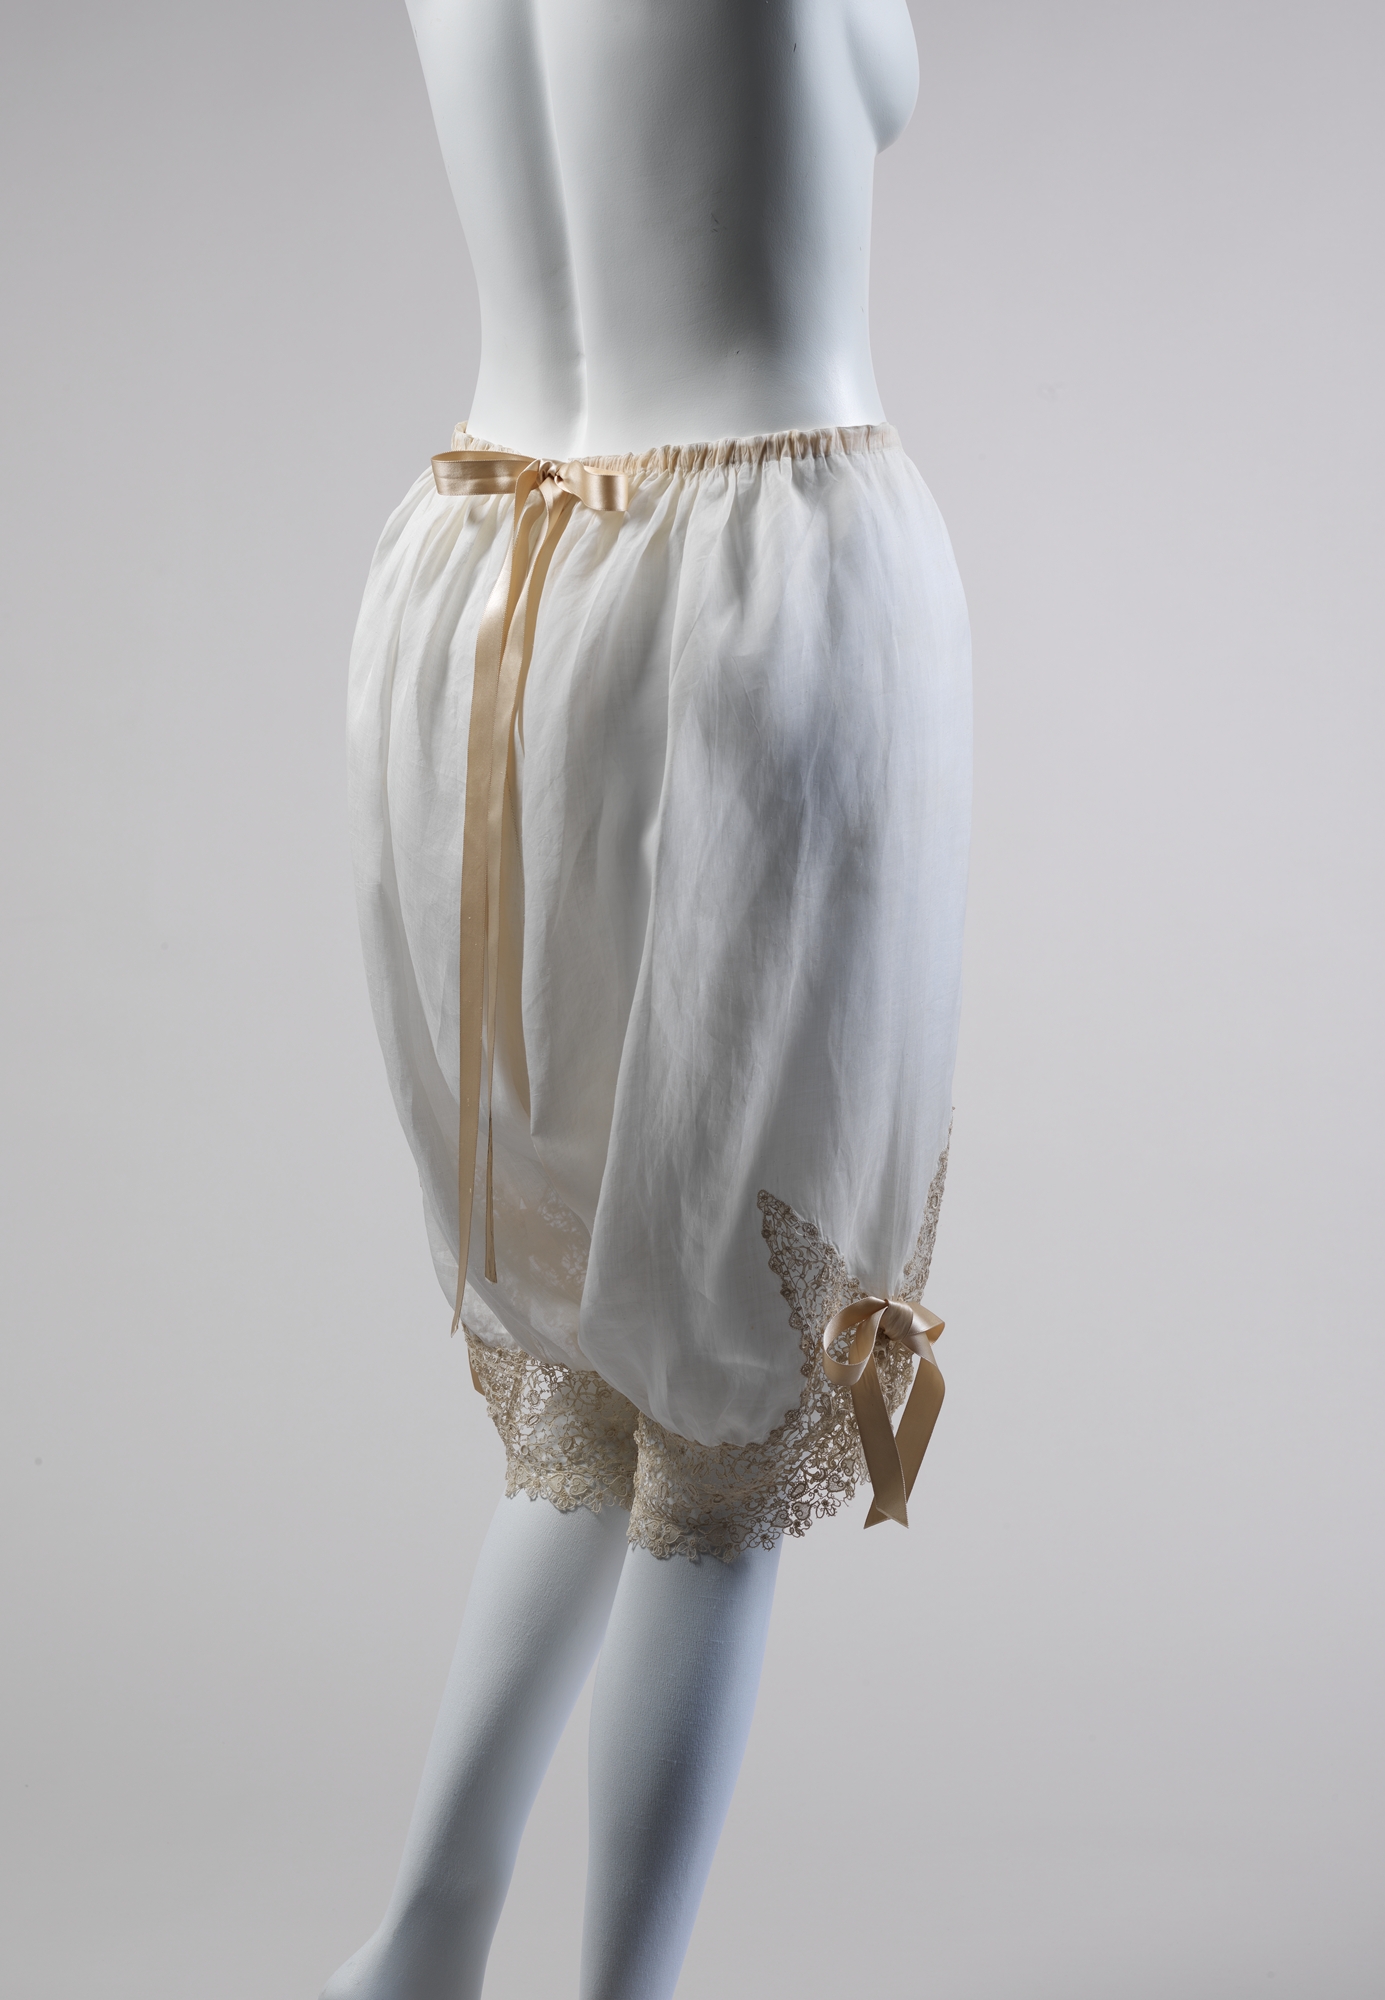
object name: drawer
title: Drawers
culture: french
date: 1890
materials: cotton